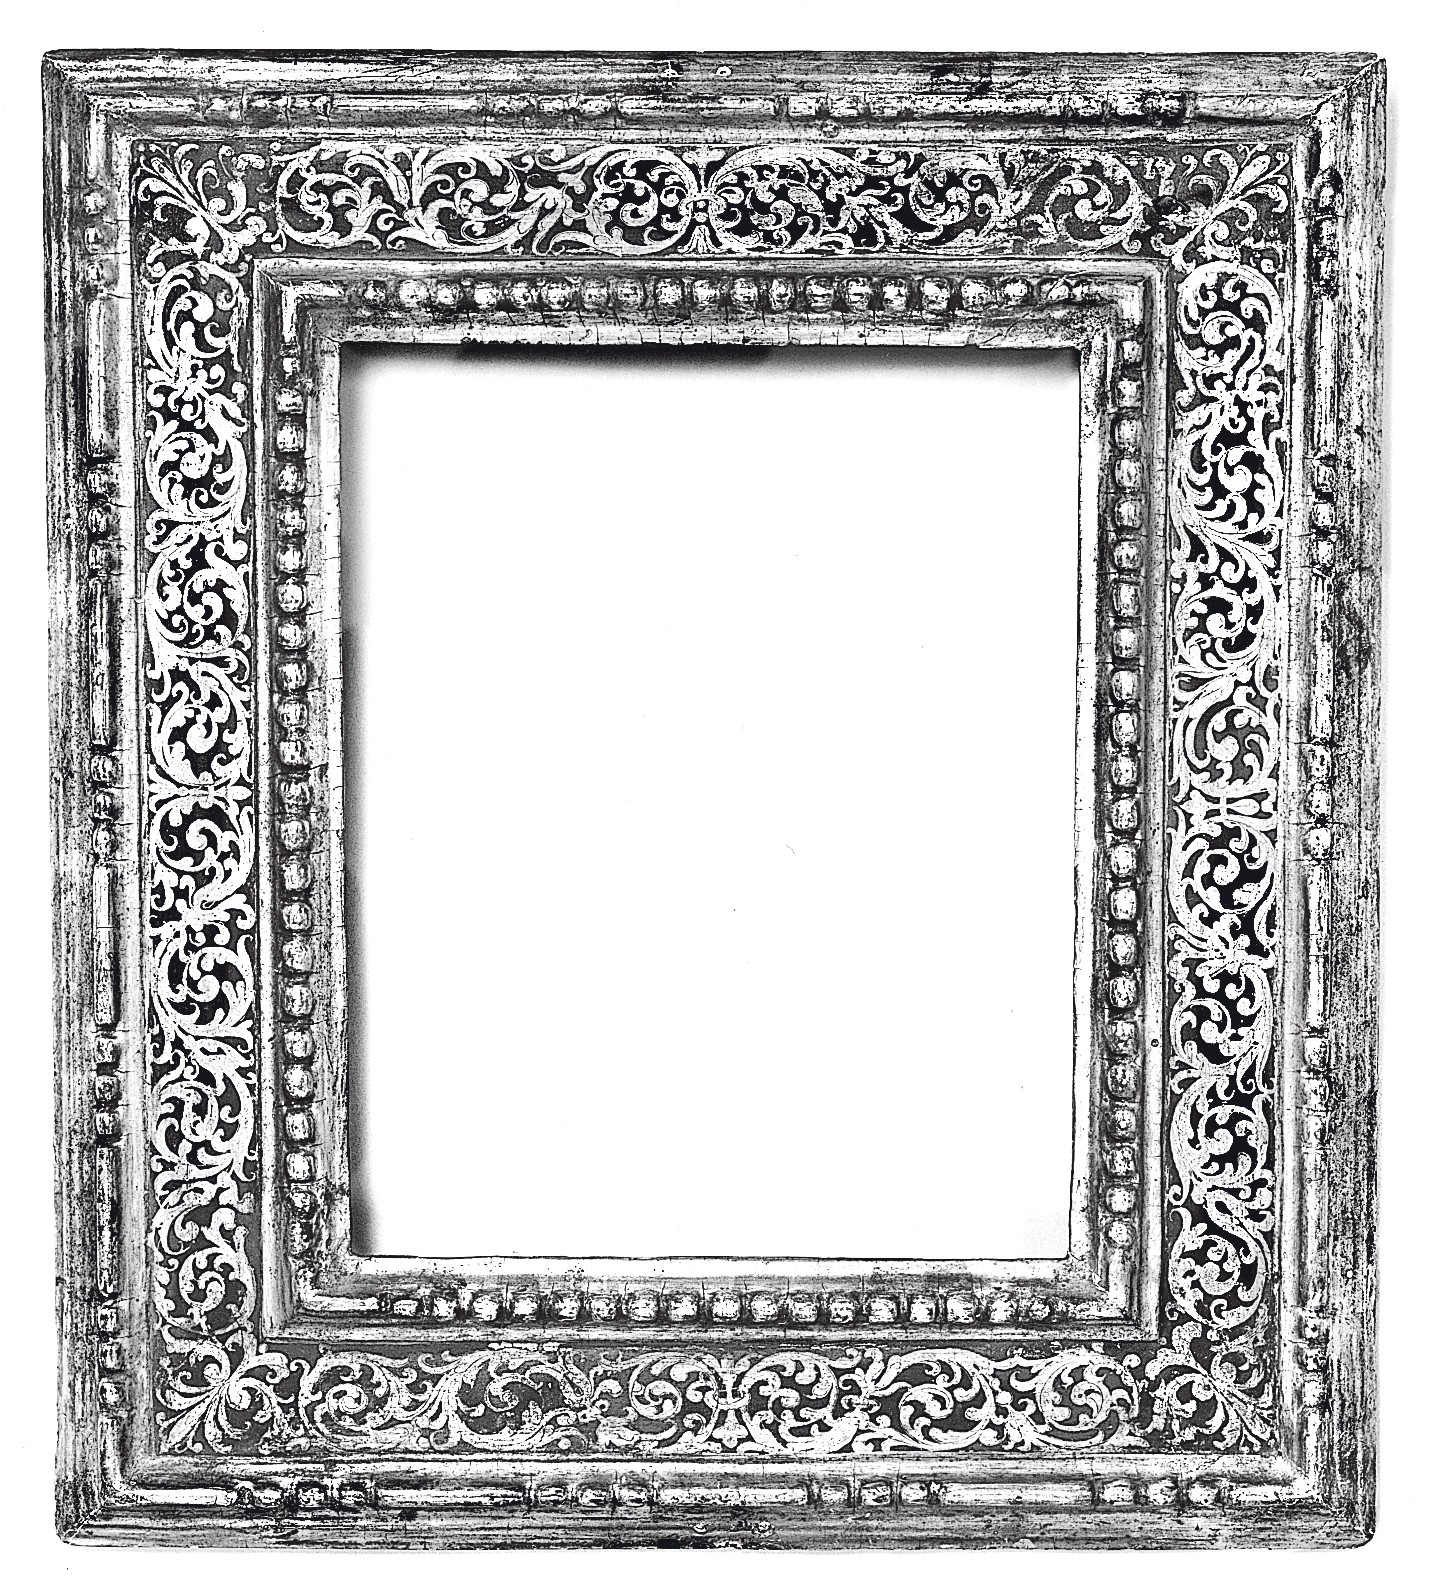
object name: frame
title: Cassetta frame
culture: italian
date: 1567-1600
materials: wood